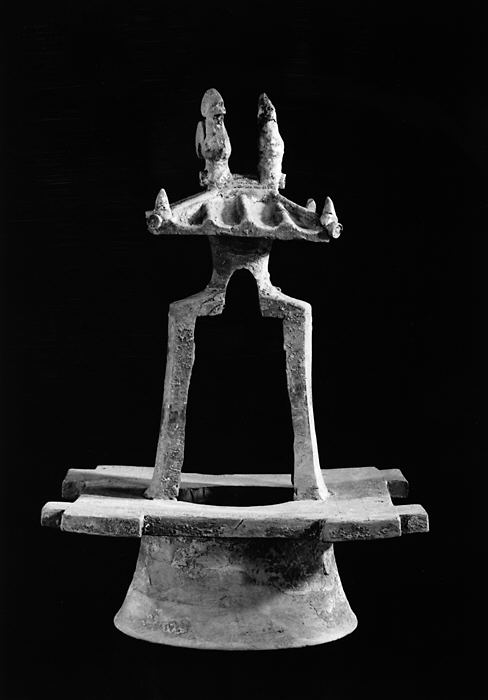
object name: wellhead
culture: chinese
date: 25-220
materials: terracotta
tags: roosters